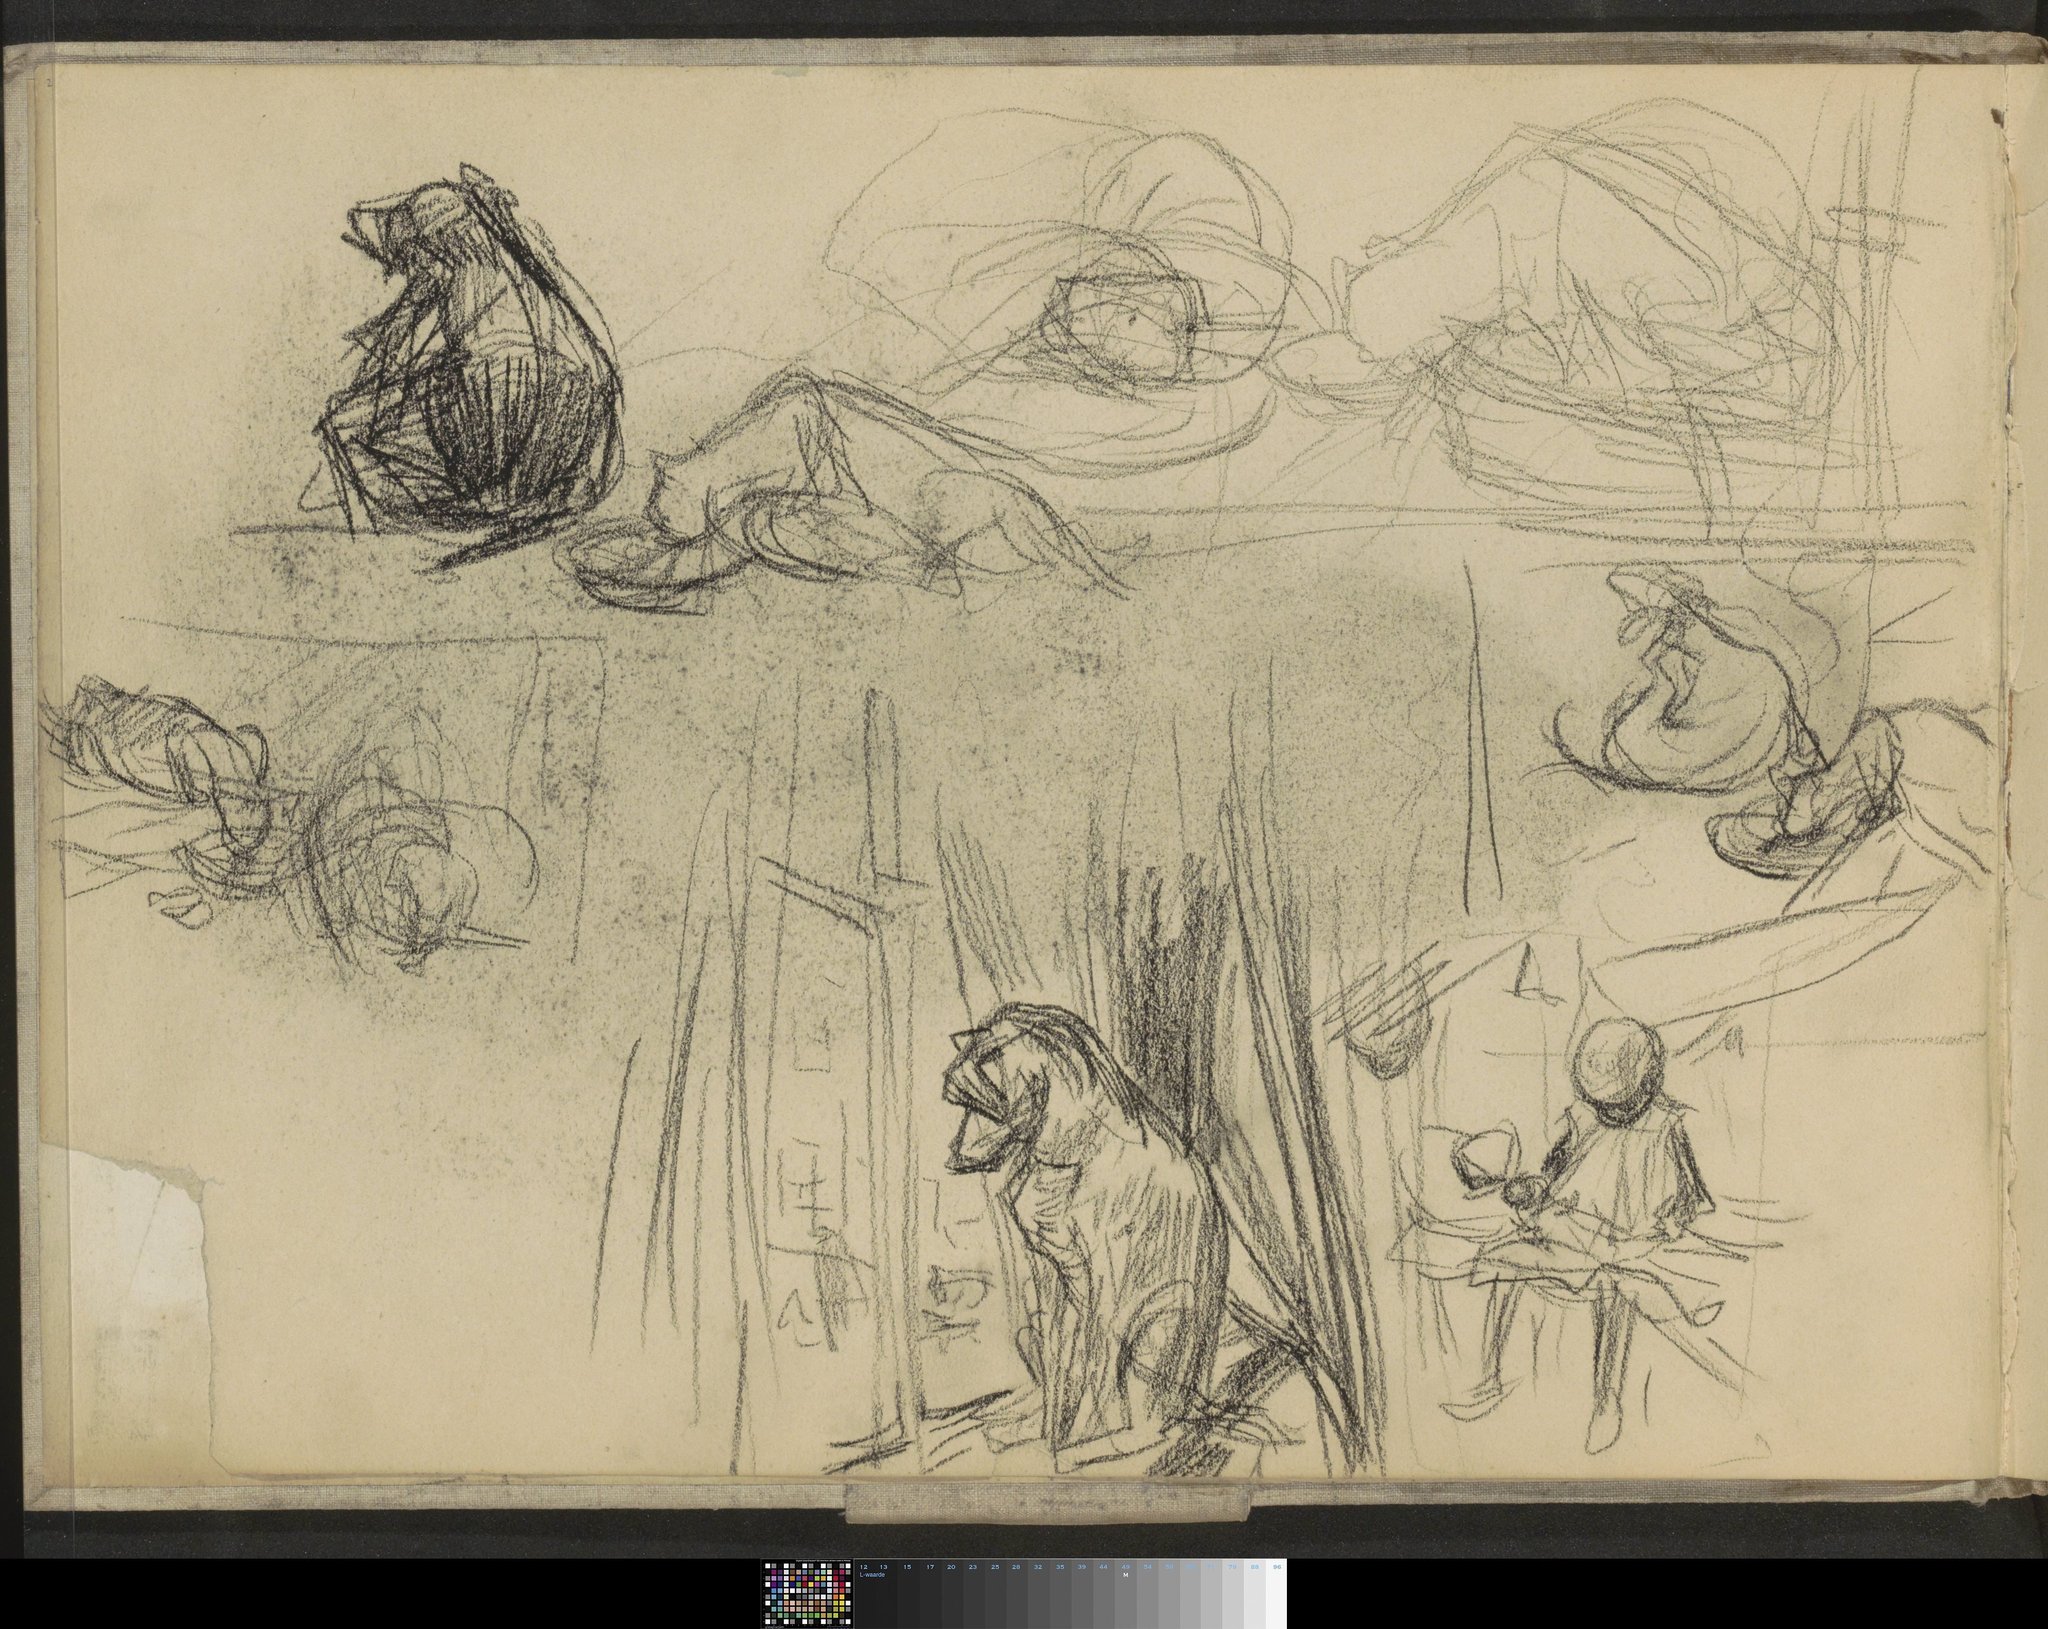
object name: sketchbook leaf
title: Studieblad, onder andere met een hond bij een raam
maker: marius bauer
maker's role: draughtsman, print maker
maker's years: 1867-1932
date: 1887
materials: chalk, paper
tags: sitting figure, child, closed window, dog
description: Tevens een studie van een zittend kind en honden in verschillende houdingen. Pagina 2 uit een schetsboek met 19 bladen.